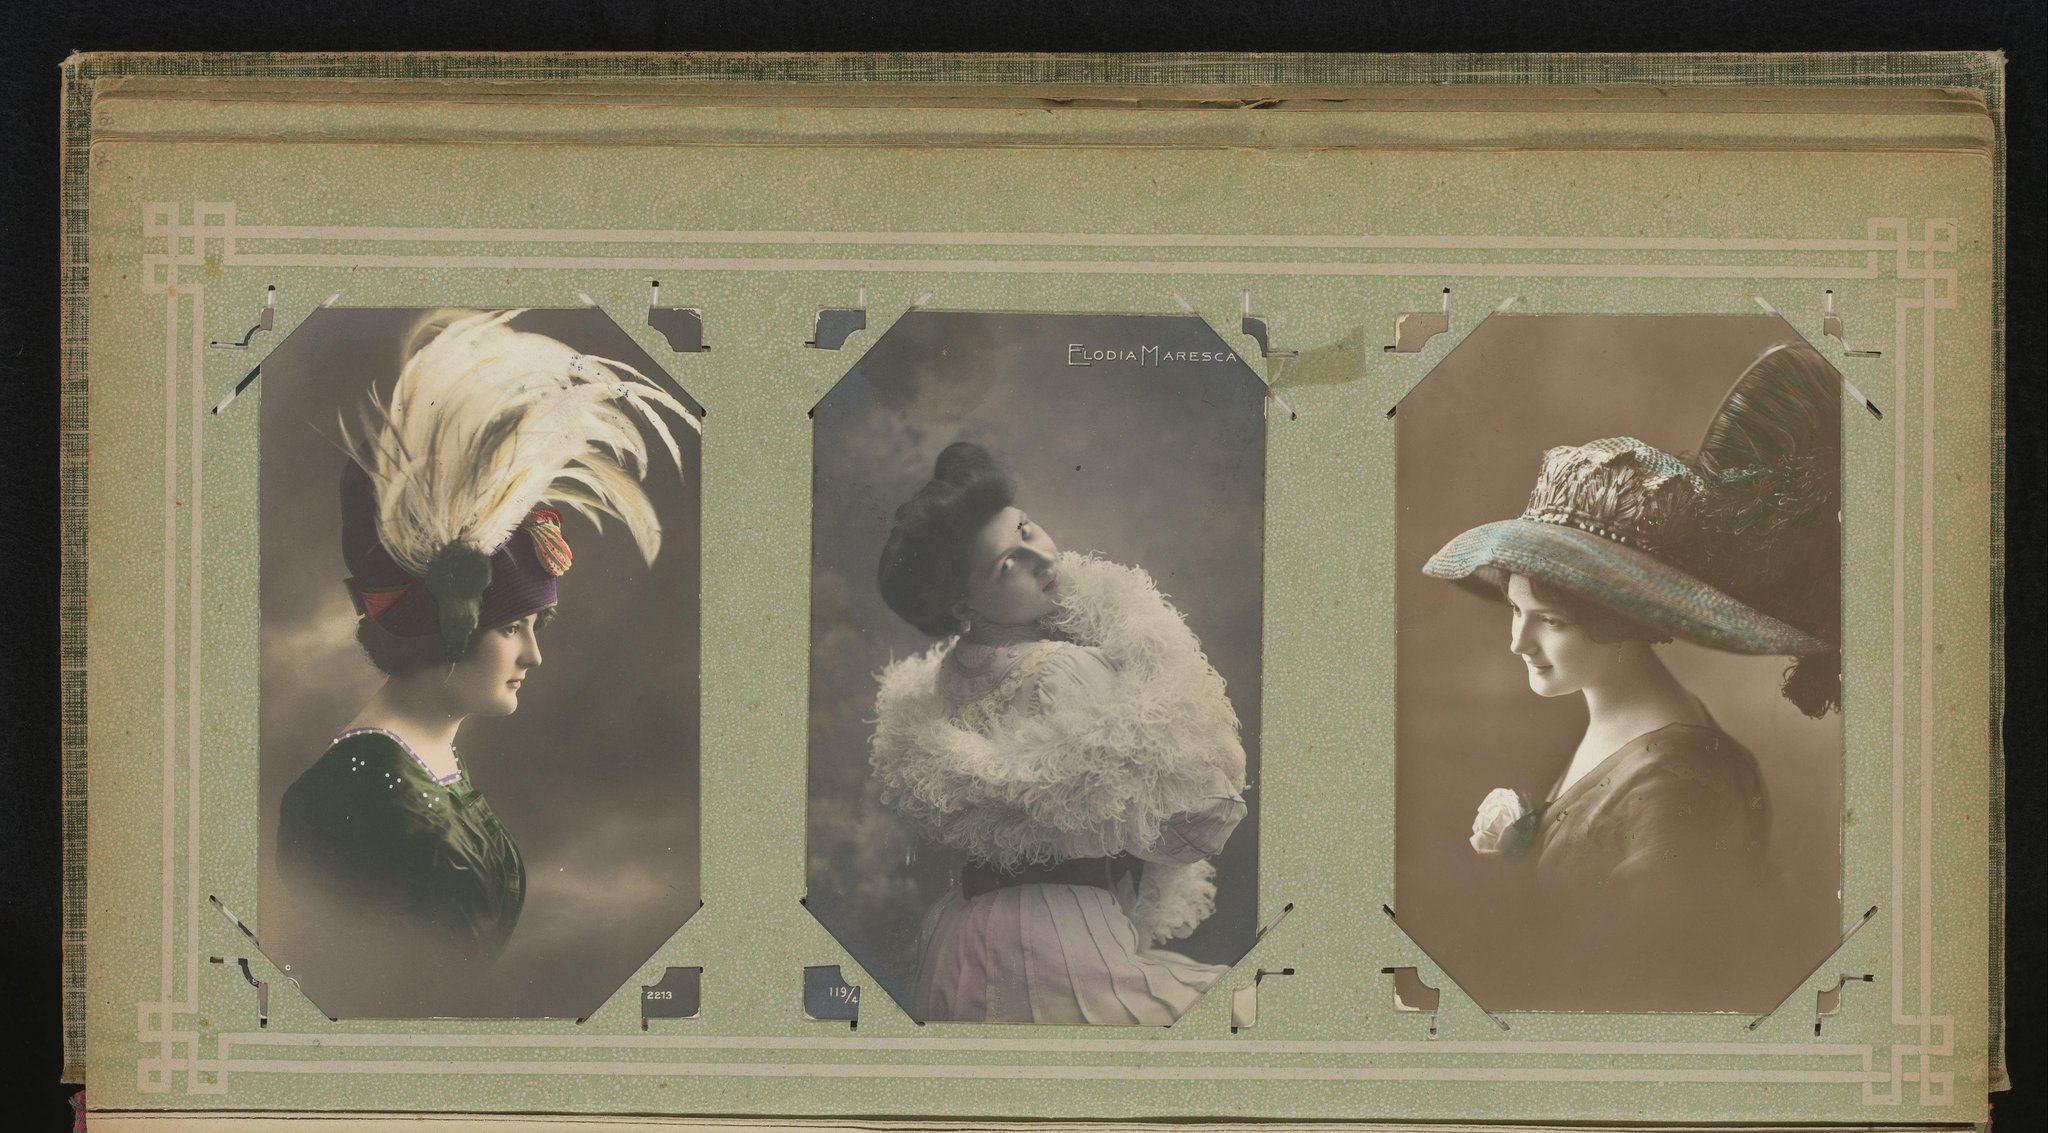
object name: ansichtkaart, prentbriefkaart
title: Drie portretten van actrices, onder wie Elodia Maresca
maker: Anonymous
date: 1900-1930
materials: cardboard, photographic support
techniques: gelatin silver print, hand coloring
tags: historical persons - bb - woman, portrait of actor, actress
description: Deze foto's maken deel uit van een album.